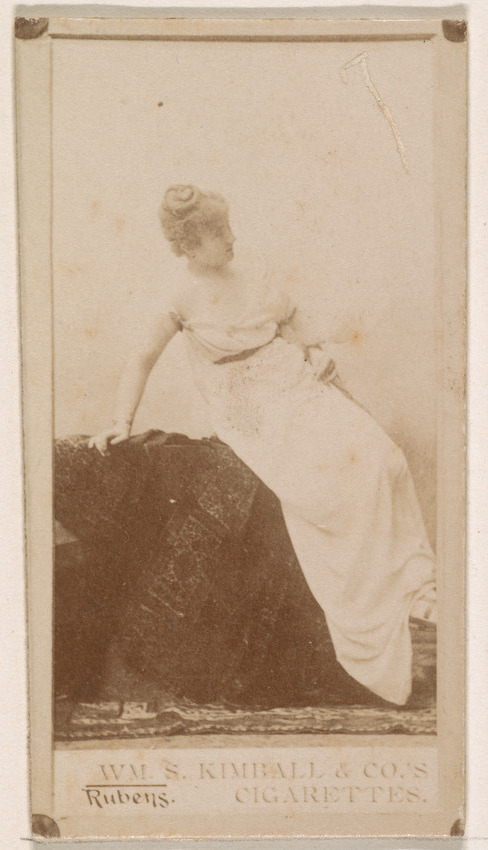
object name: photograph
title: Miss Rubens, from the Actresses series (N203) issued by Wm. S. Kimball & Co.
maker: william s. kimball & company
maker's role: publisher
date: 1889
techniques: color lithograph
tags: portraits,women,actresses